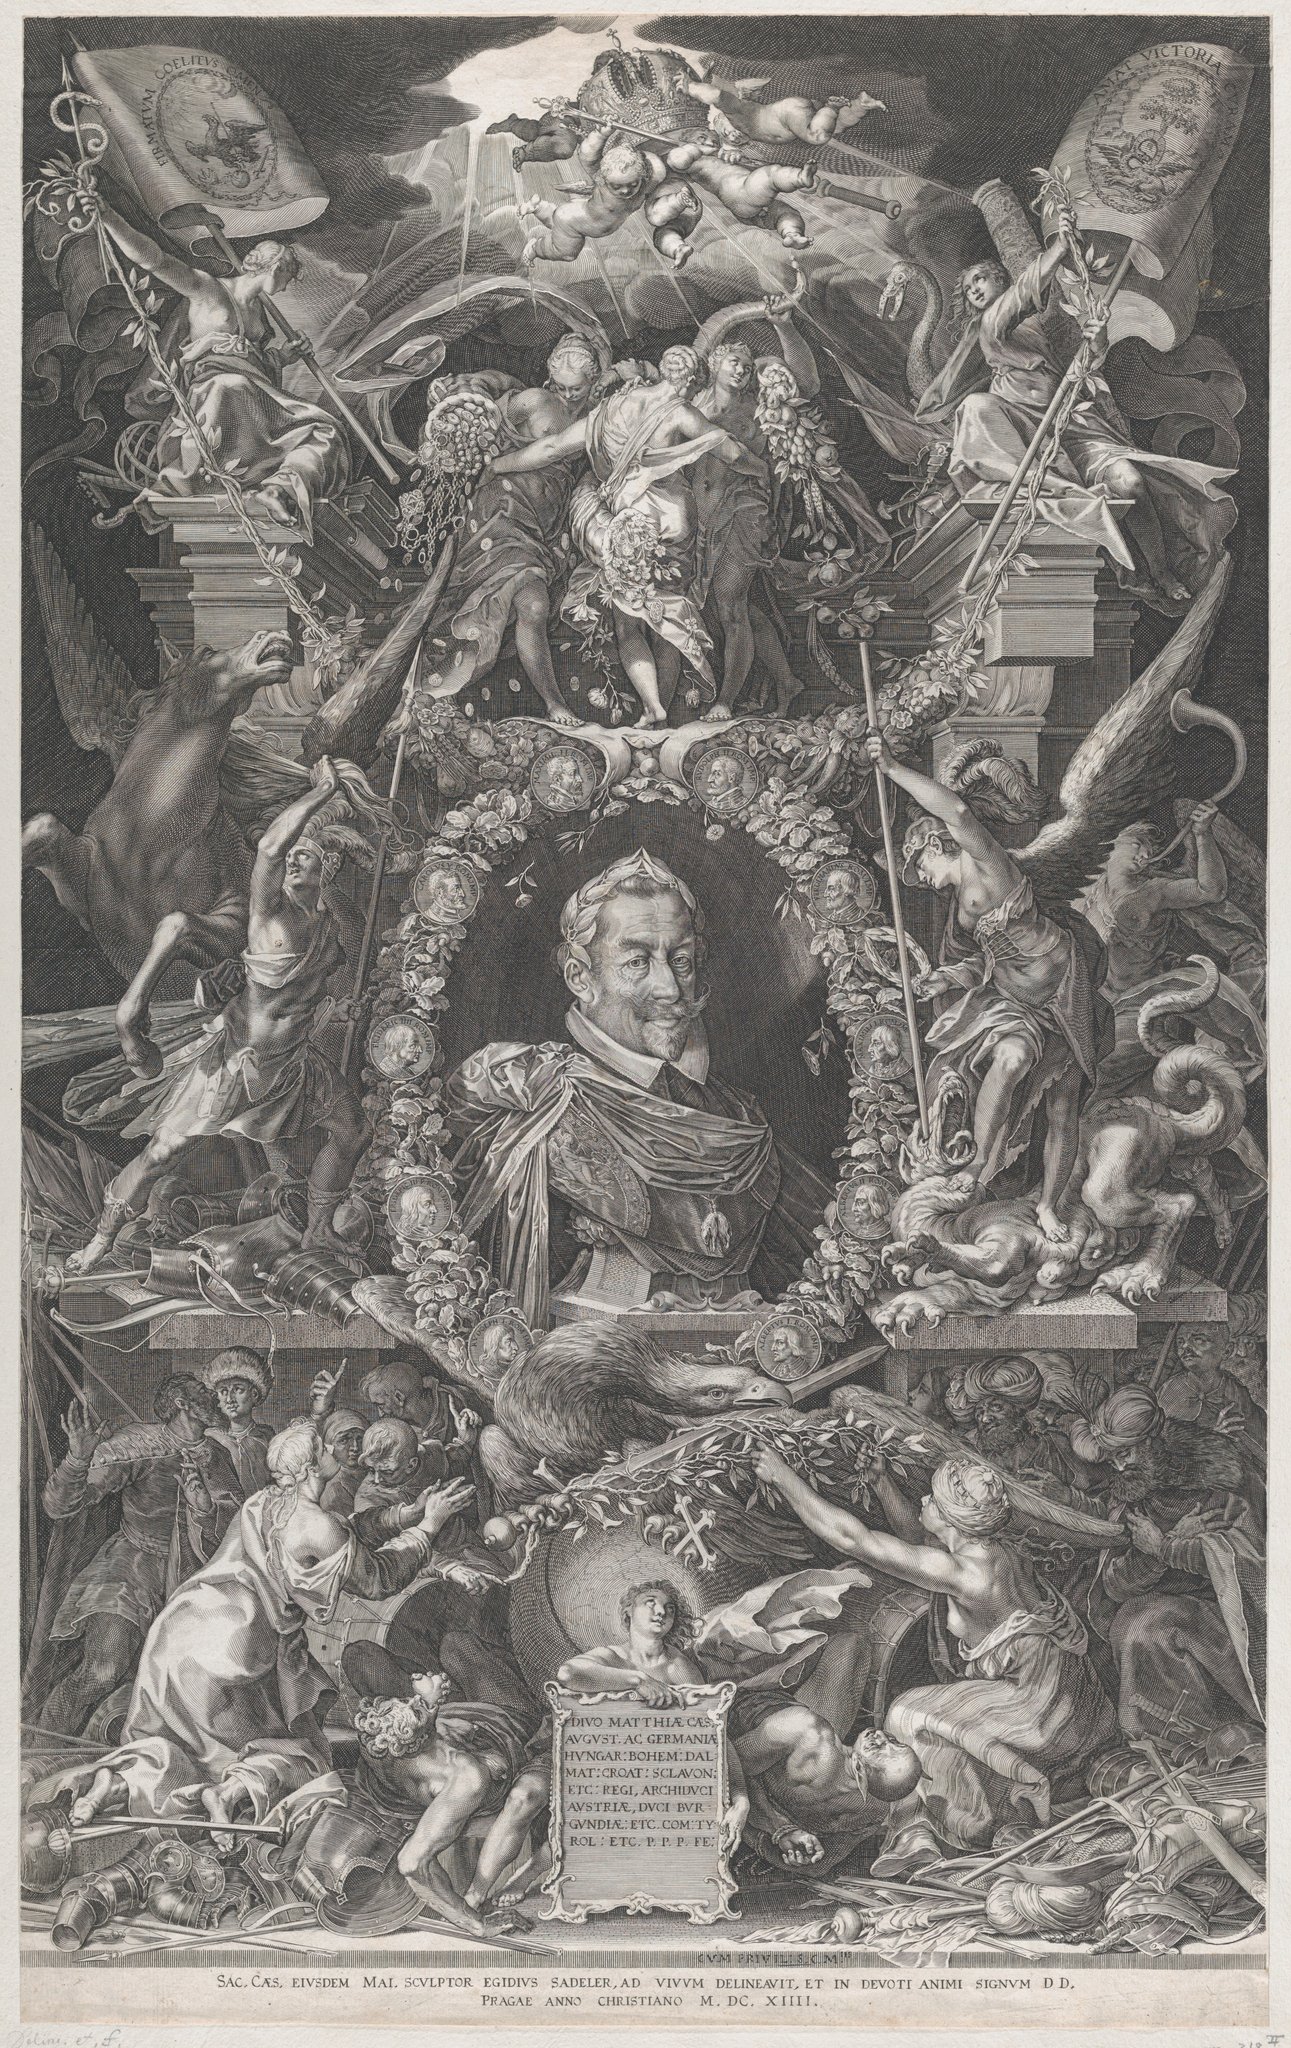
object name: print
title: Emperor Matthias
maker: aegidius sadeler (ii)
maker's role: artist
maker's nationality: flemish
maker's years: 1568-1629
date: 1614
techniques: engraving